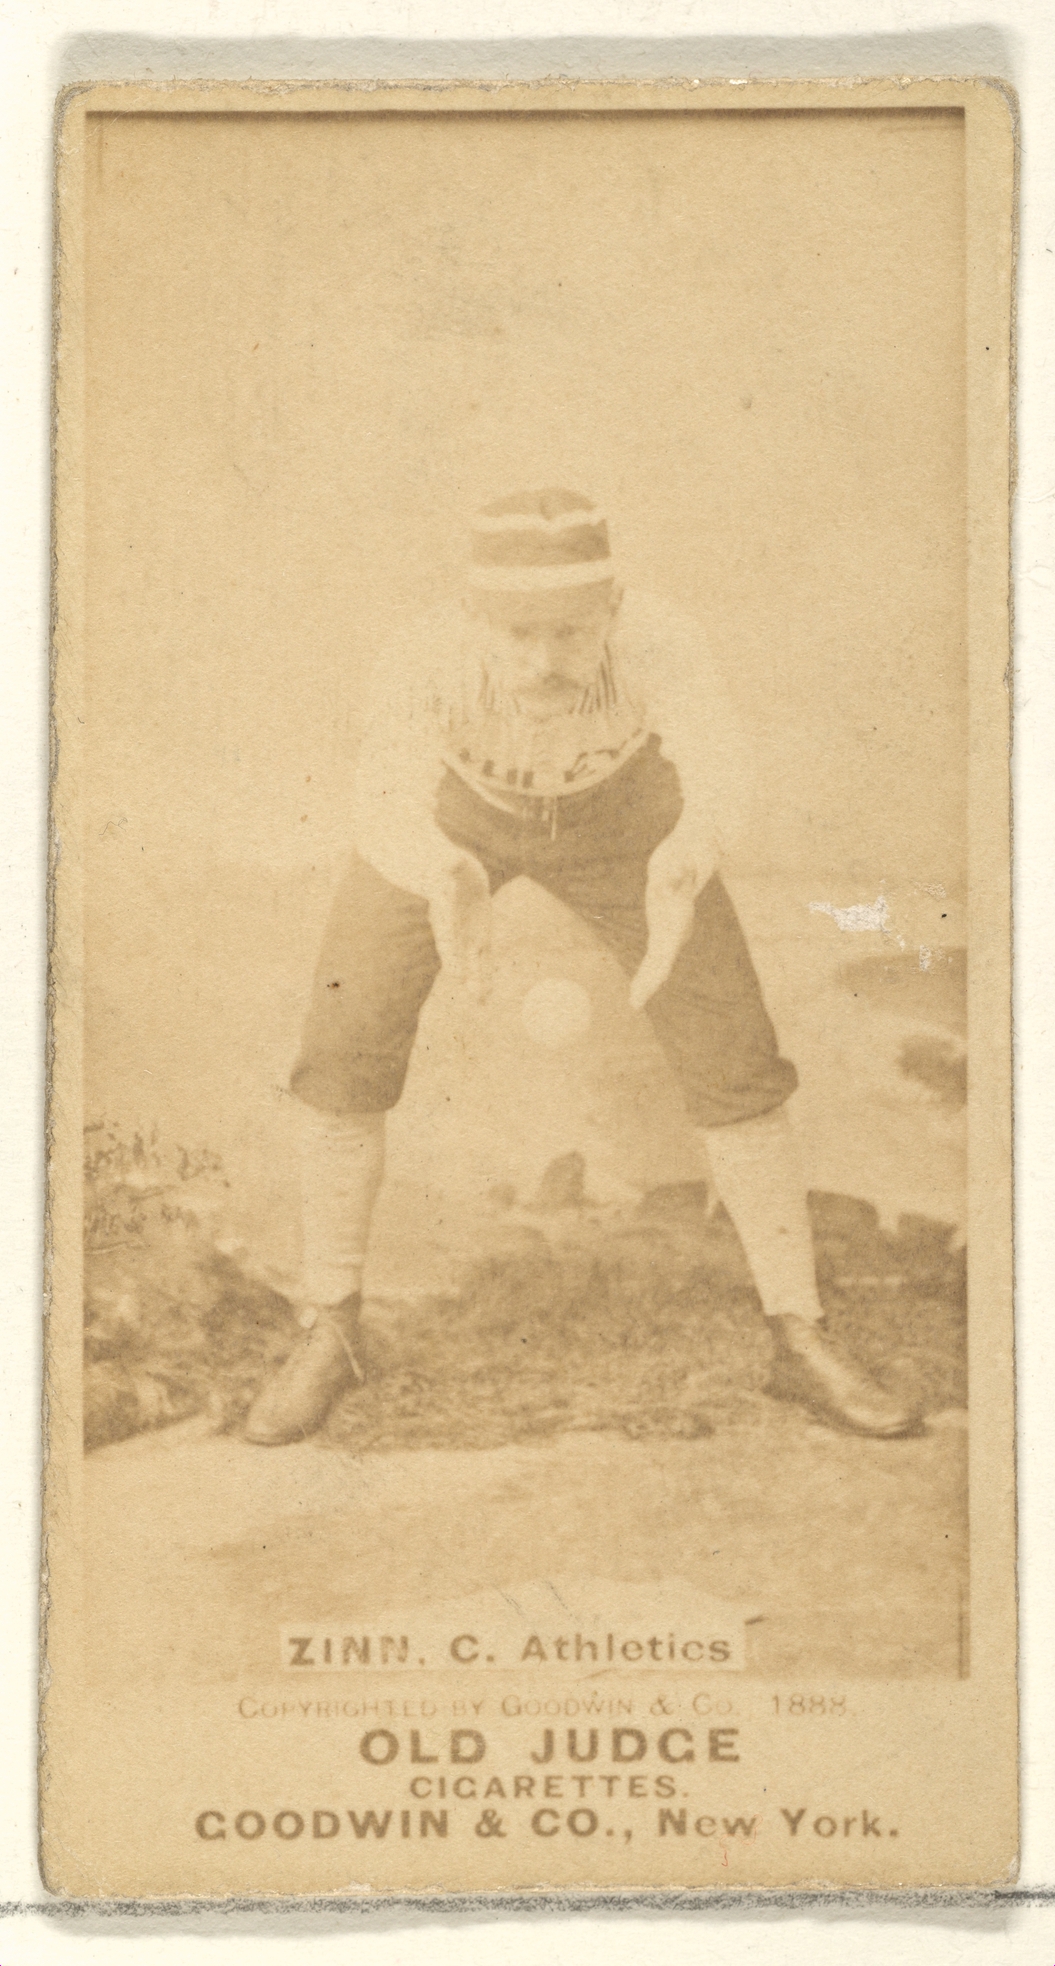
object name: baseball card, photograph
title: Zinn, Catcher, Philadelphia Athletics, from the Old Judge series (N172) for Old Judge Cigarettes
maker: goodwin & company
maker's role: publisher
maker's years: 1850-1950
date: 1888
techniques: albumen silver print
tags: men,portraits,baseball,athletes